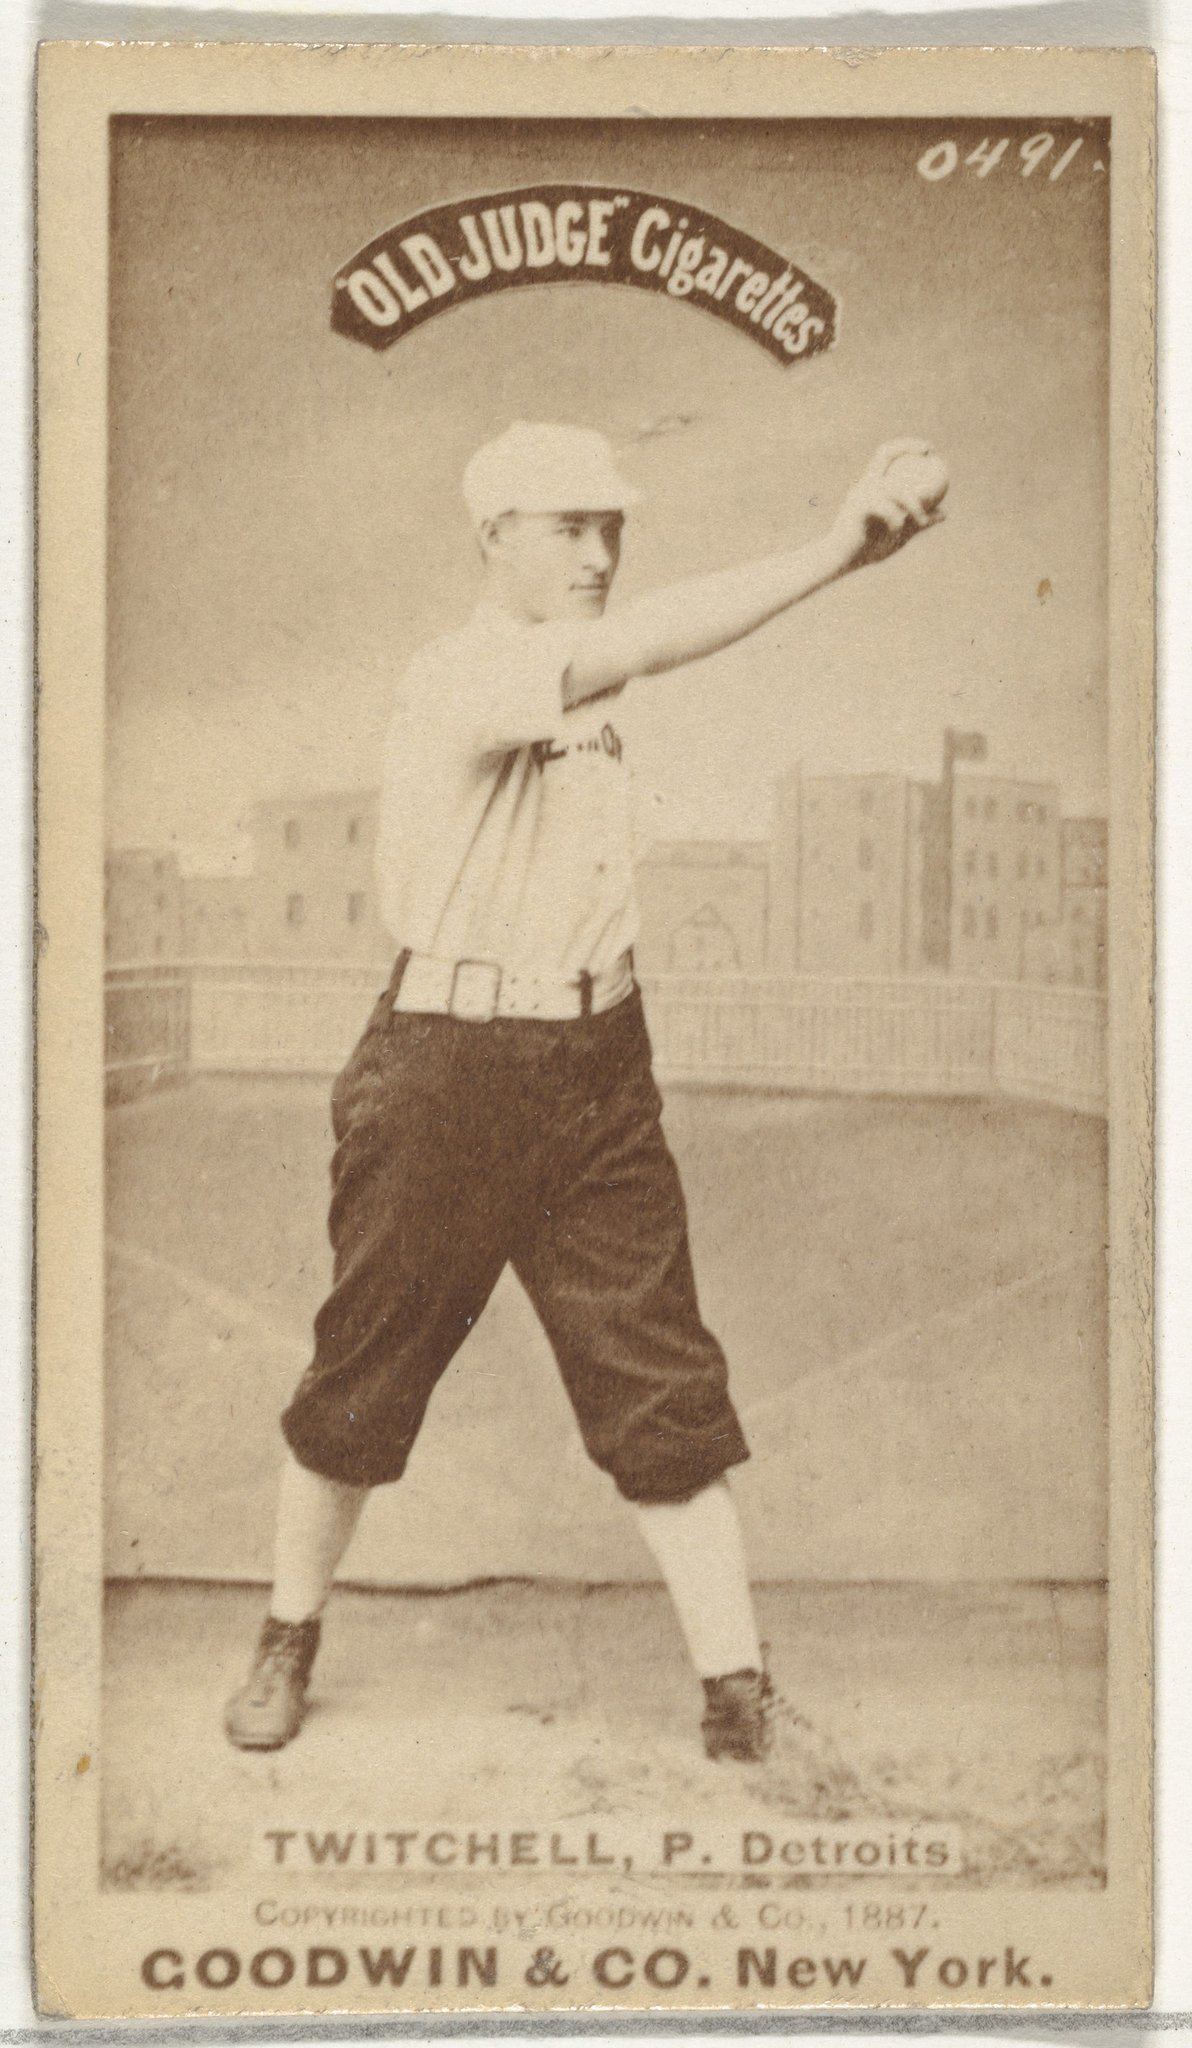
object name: baseball card, photograph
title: Lawrence Grant "Larry" Twitchell, Pitcher, Detroit Wolverines, from the Old Judge series (N172) for Old Judge Cigarettes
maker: goodwin & company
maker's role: publisher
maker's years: 1850-1950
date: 1887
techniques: albumen silver print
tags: men,portraits,baseball,athletes